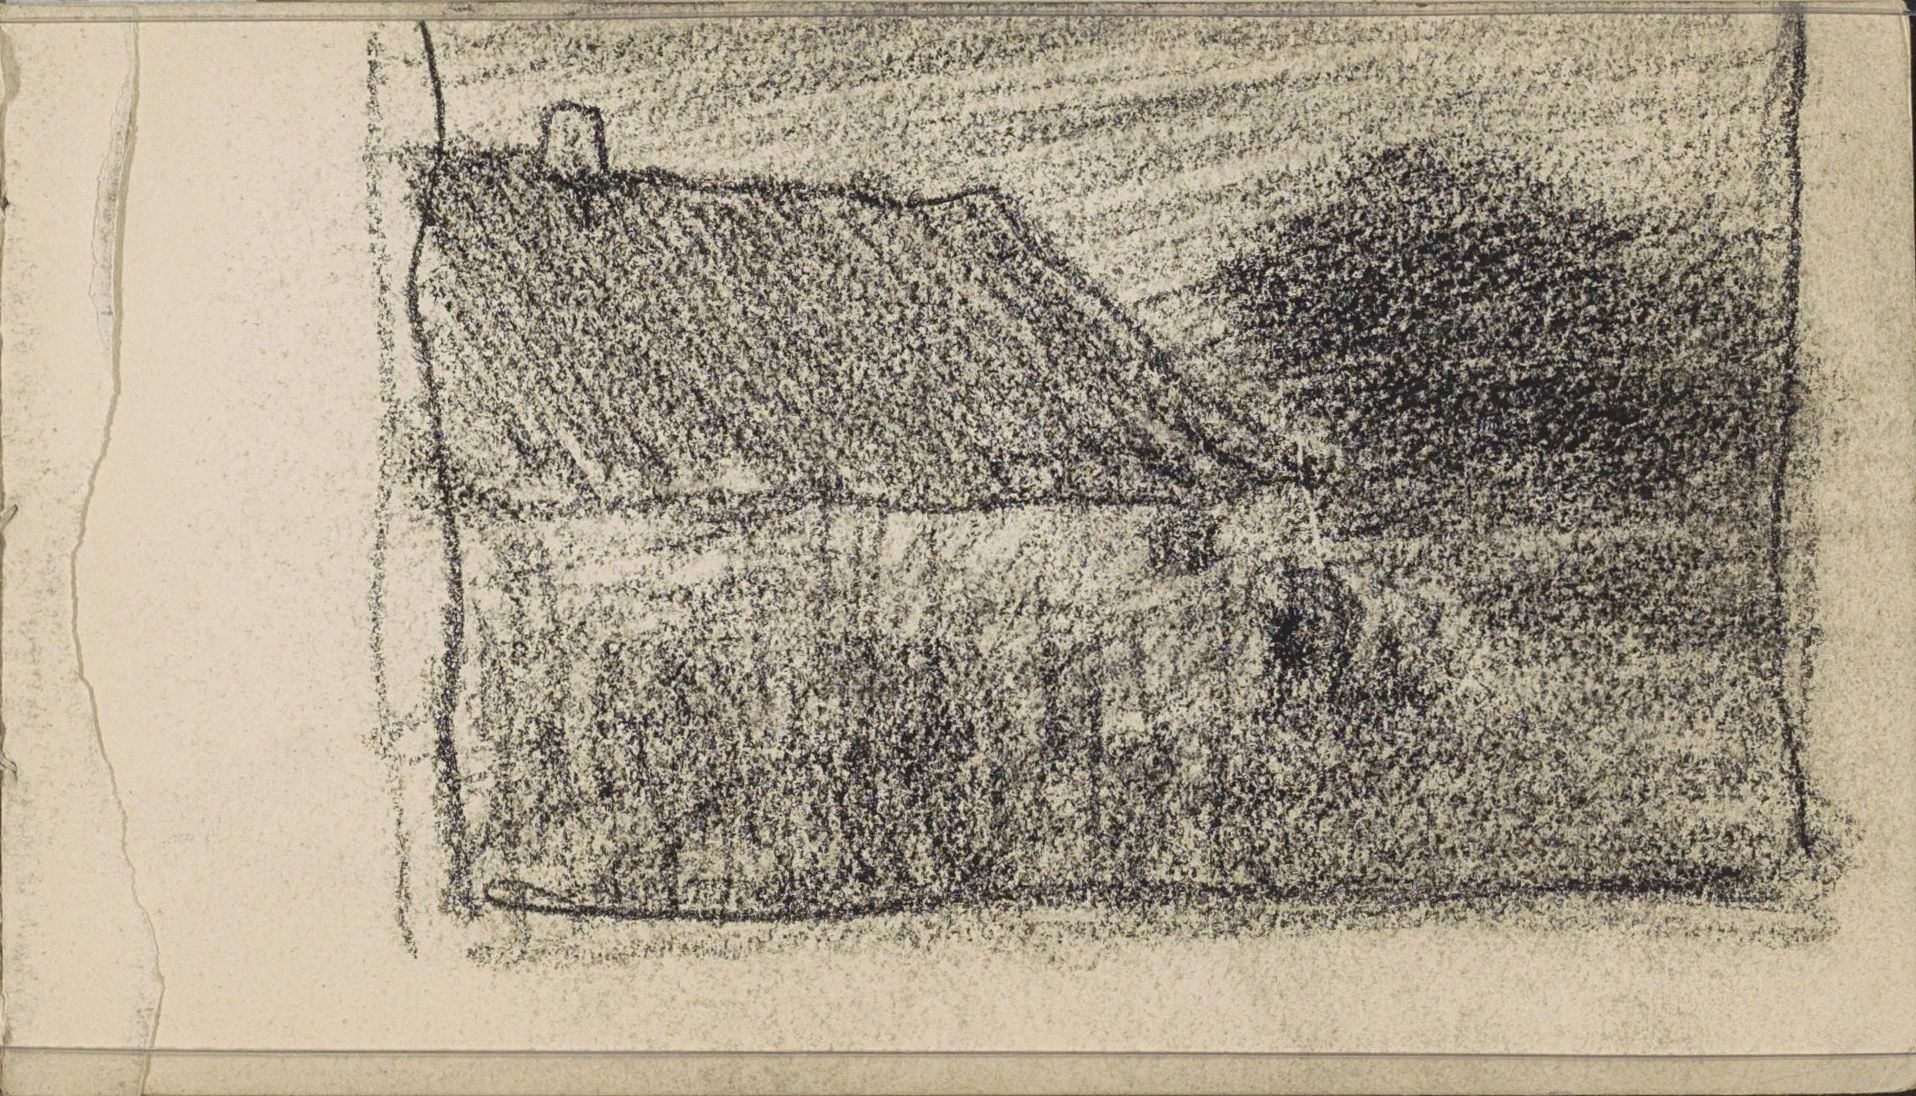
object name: sketchbook leaf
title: Plattelandswoning met een schuin dak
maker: anton mauve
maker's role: draughtsman, painter, print maker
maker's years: 1838-1888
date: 1876-1879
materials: chalk, paper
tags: farm or solitary house in landscape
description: Blad 5 recto uit een schetsboek met 33 bladen.